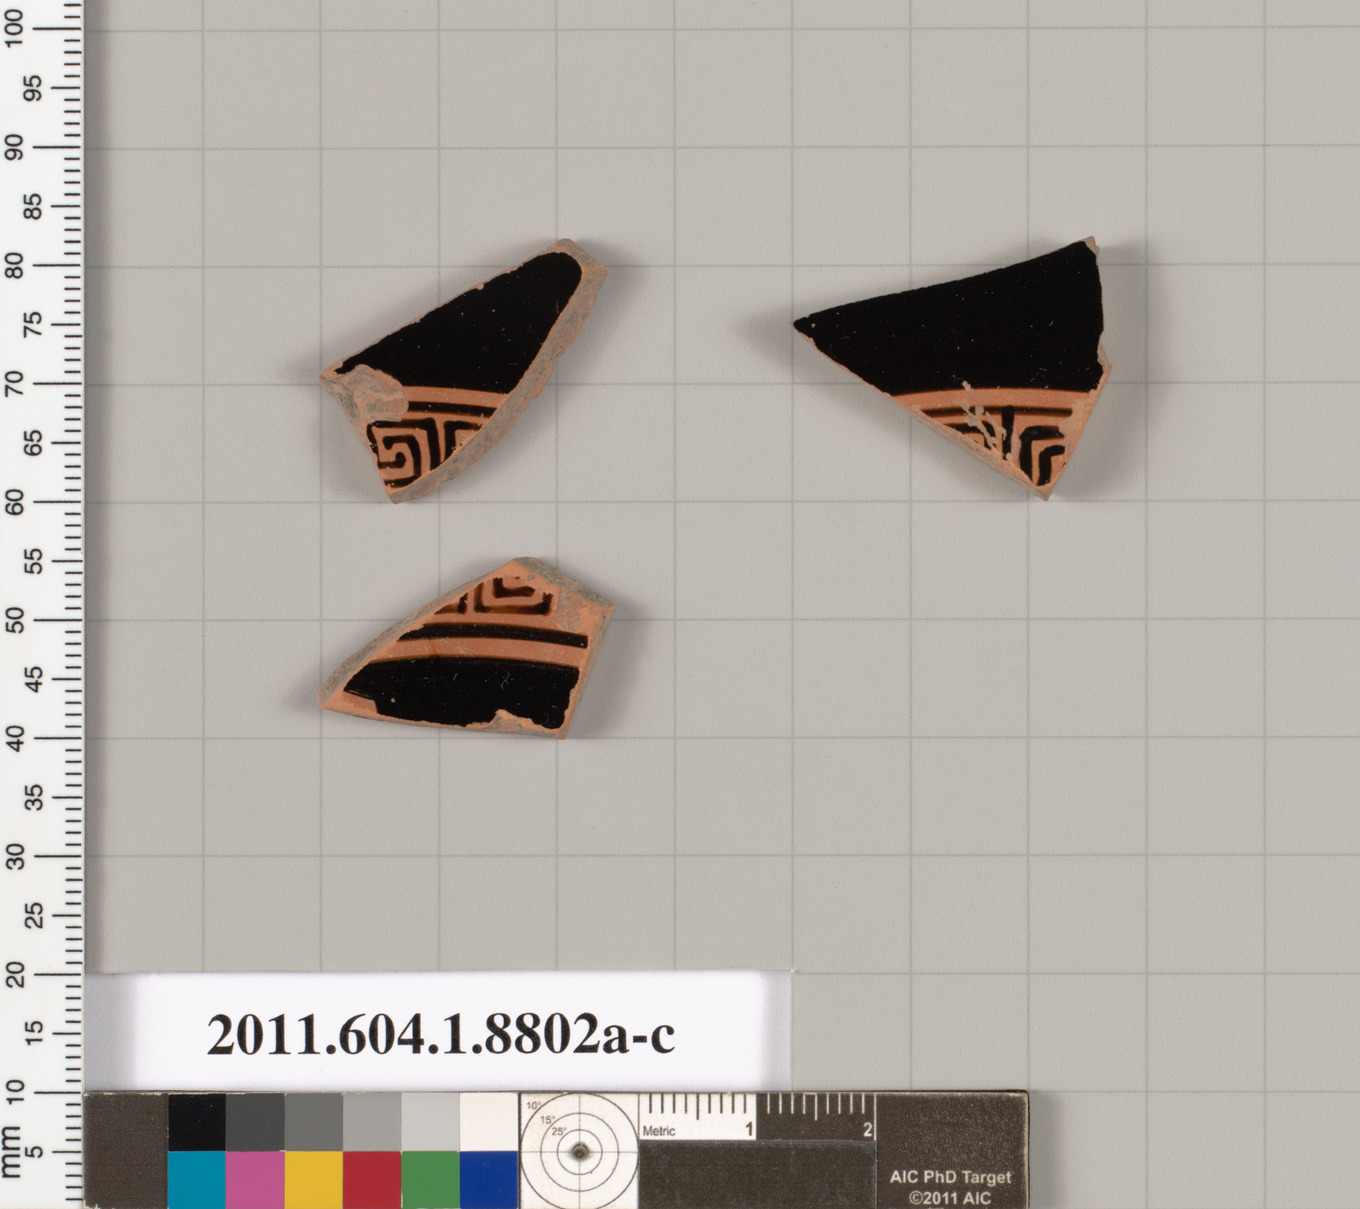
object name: kylix fragment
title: Terracotta fragments of kylikes (drinking cups)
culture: greek, attic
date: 490-480 BCE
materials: terracotta